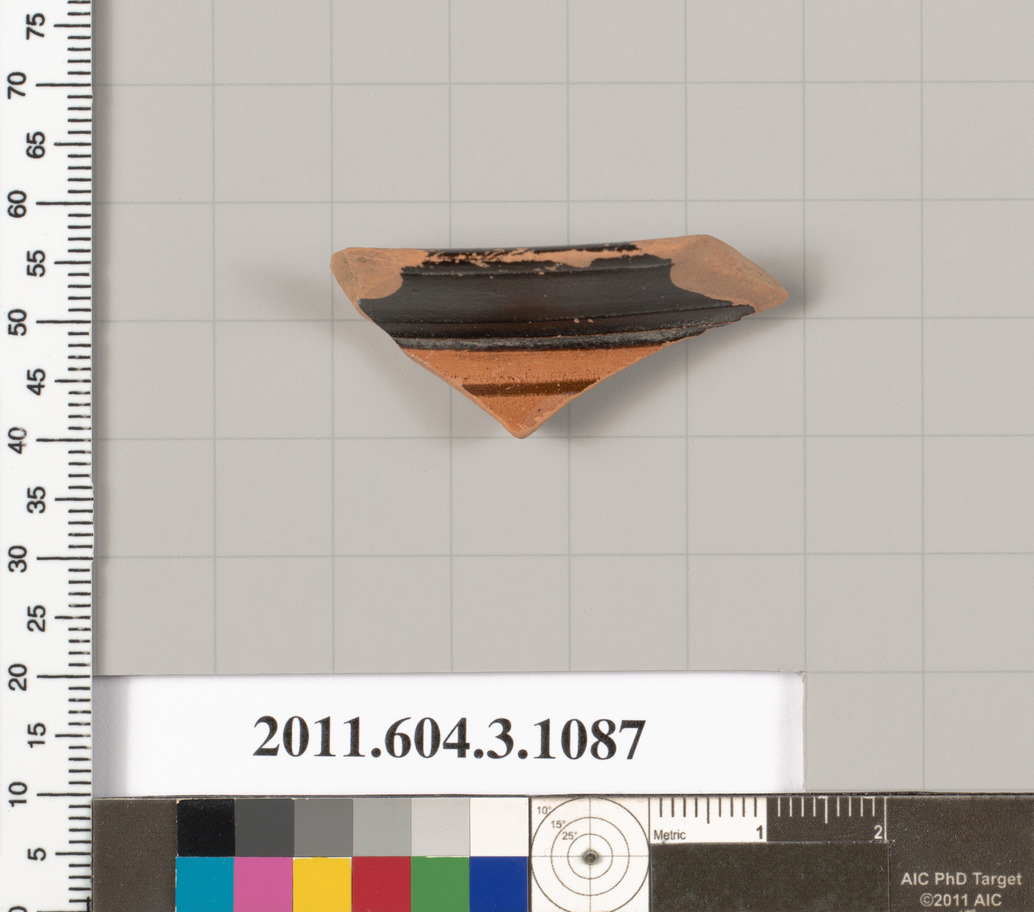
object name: mastoid fragment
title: Terracotta rim fragment of a mastoid (drinking cup with narrow base)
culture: greek, attic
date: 534-468 BCE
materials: terracotta